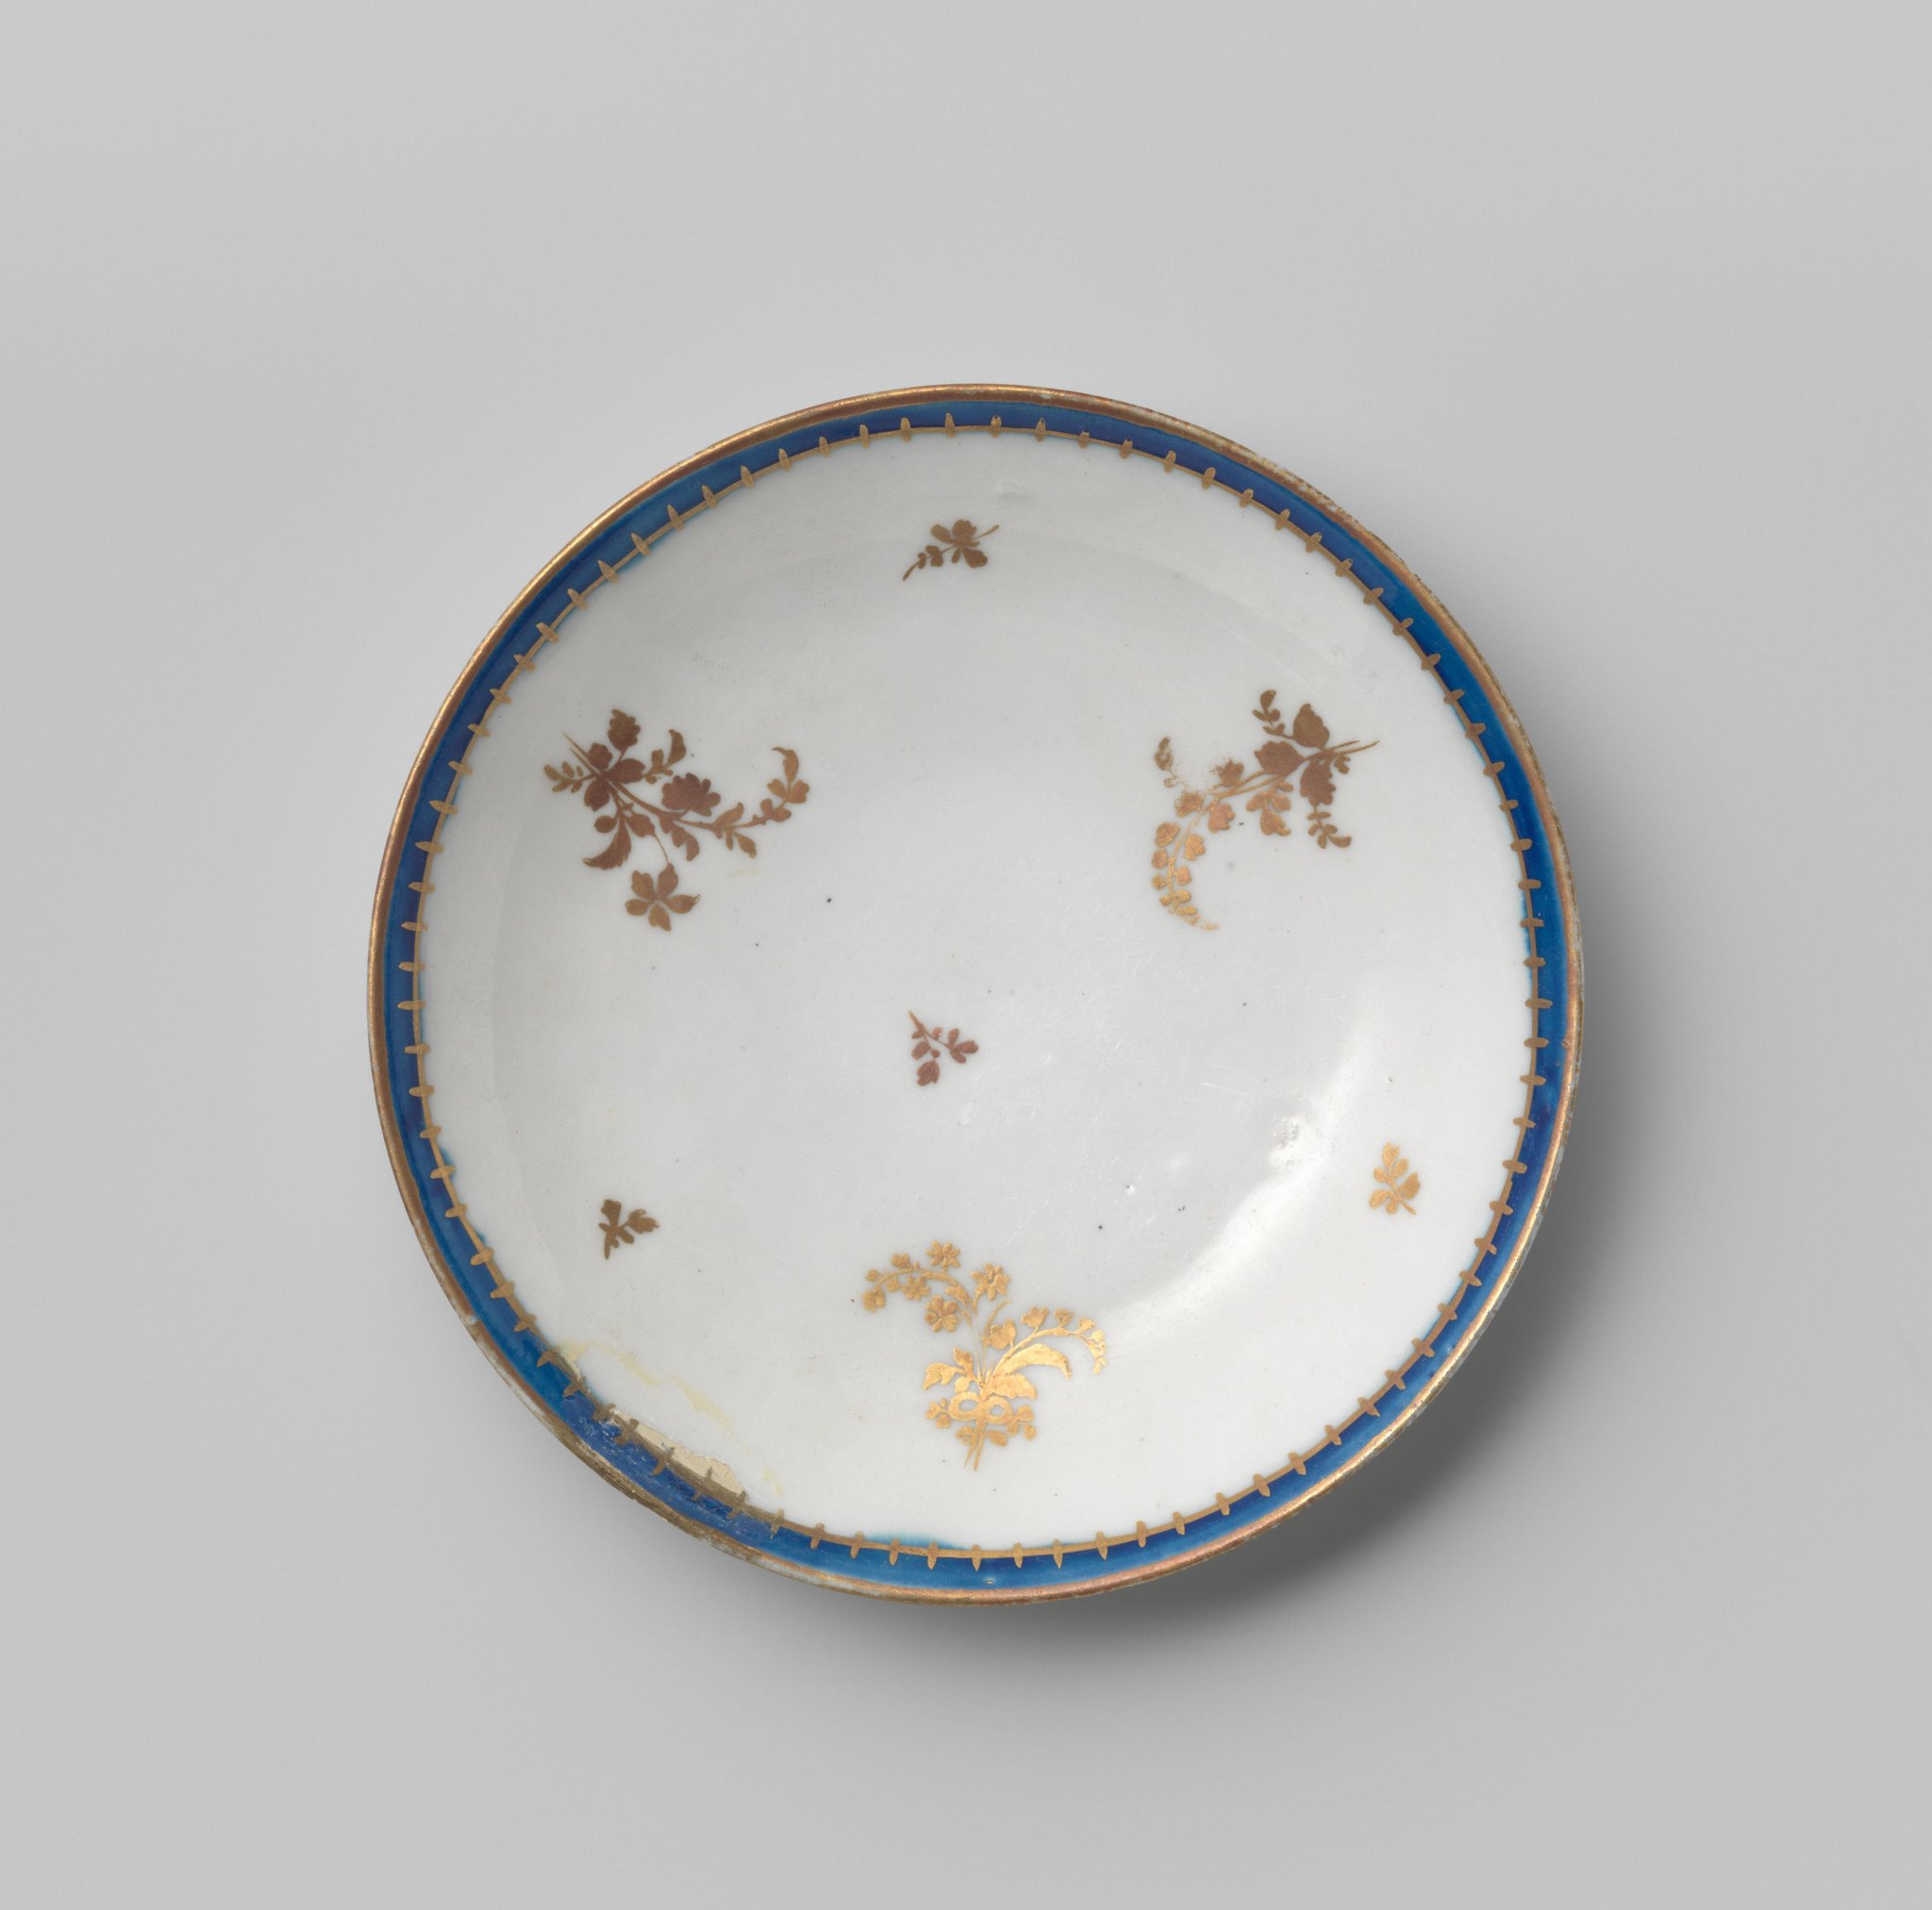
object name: platter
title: Saucer with flower sprays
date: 1765-1799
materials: glaze, gold, paint, porcelain, soft paste porcelain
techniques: firing, gilding, turning, vitrification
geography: doccia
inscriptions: mark: ‘ster’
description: Schotel van soft-paste porselein (pâte-tendre), beschilderd in onderglazuur blauw en op het glazuur goud. Op de voorzije driemaal een bloemtak, waartussen strooibloemen. De binnenrand met een decoratieve band. Gouden rand. Gemerkt op de onderzijde met de ster.